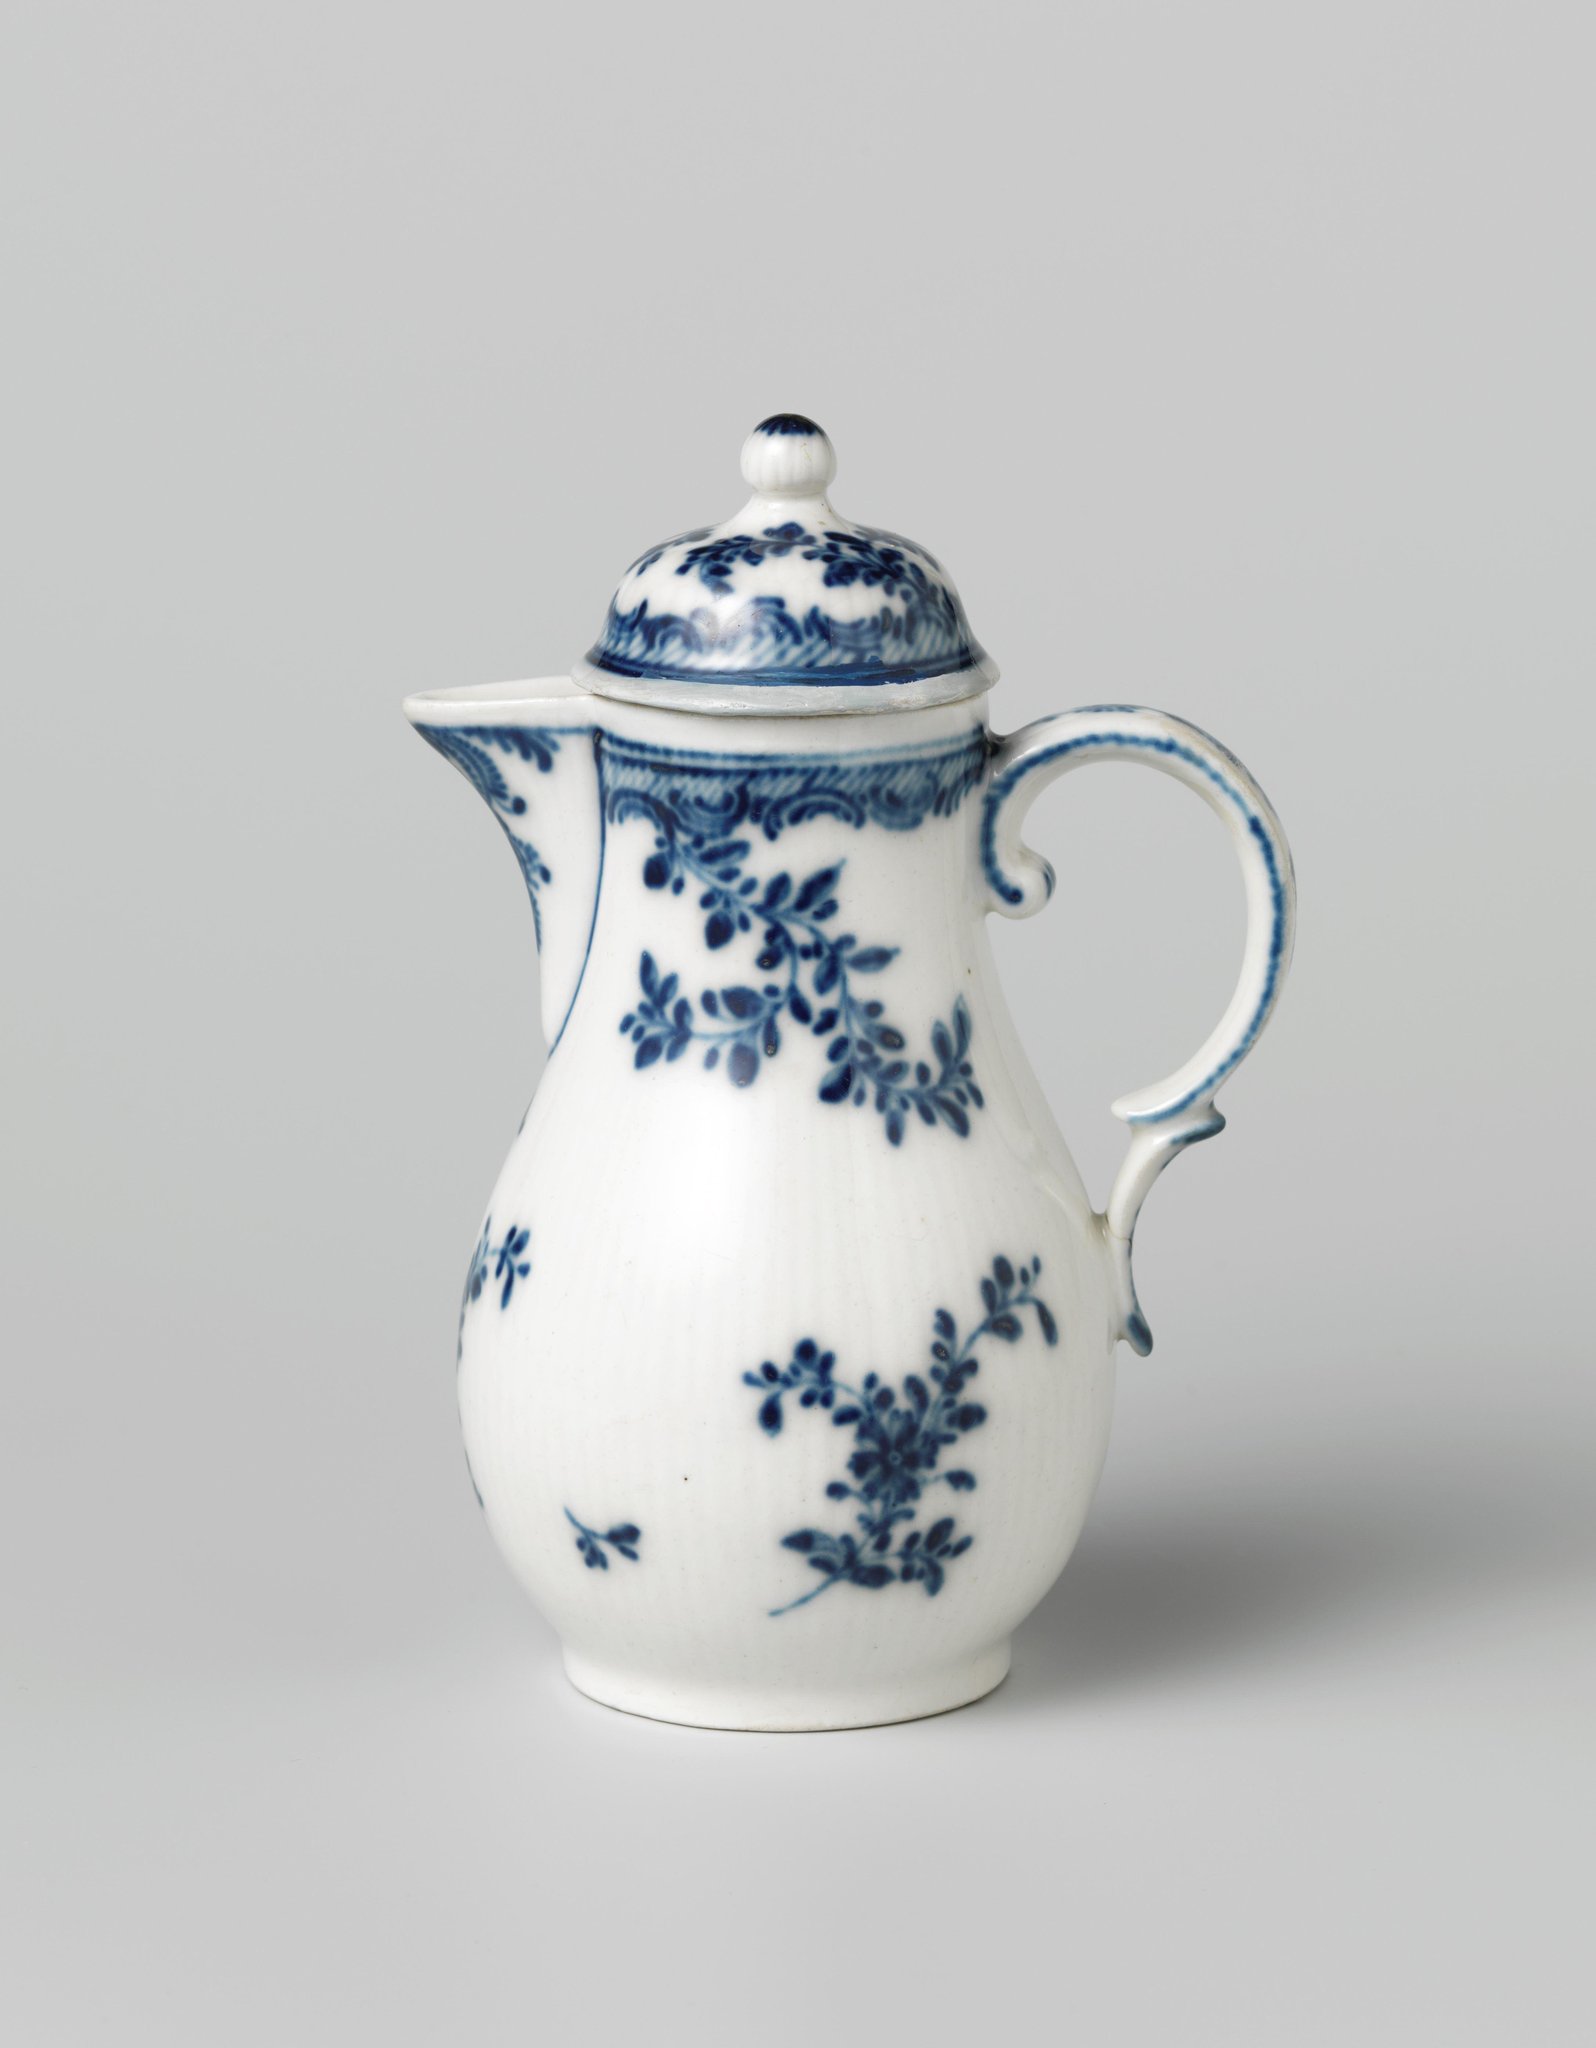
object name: lid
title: Deksel van melkkan, beschilderd met bloemtakken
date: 1778-1782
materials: porcelain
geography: loosdrecht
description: Deksel van porselein. Deksel versierd met ribben in reliëf in twee . Beschilderd in onderglazuurblauw met bloemtakken, die op het deksel afhangen van een geschilderde rocaillerand. Op de geribde knop een rozet.